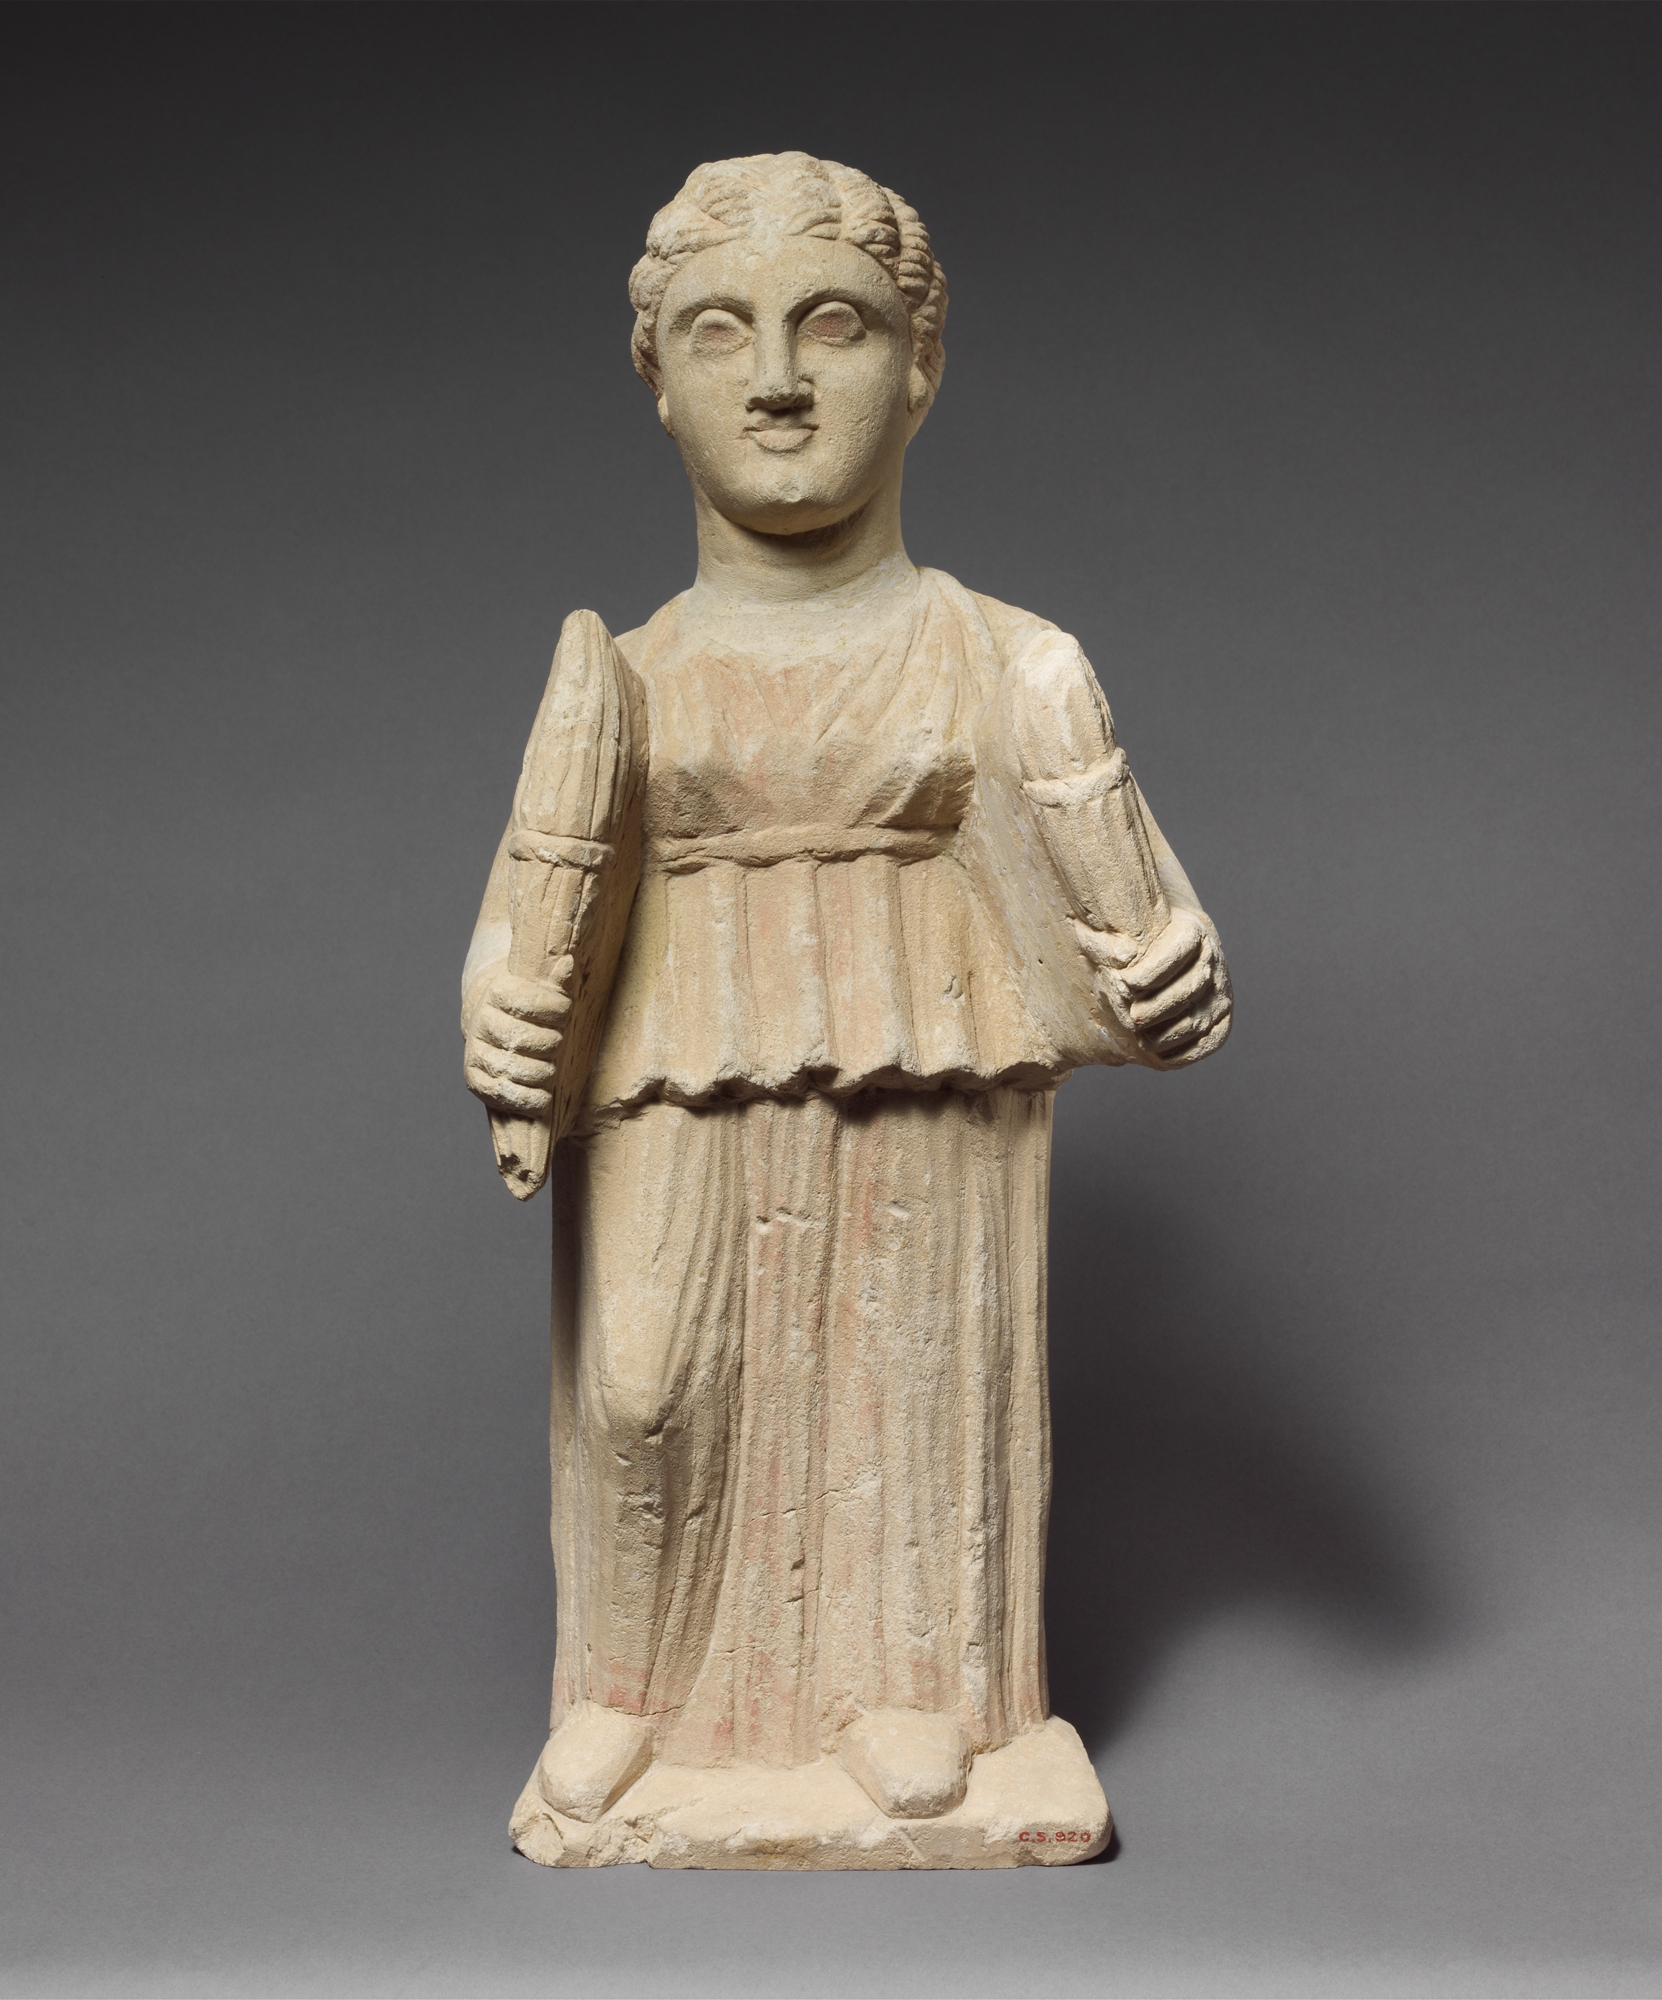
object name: statue of artemis hekate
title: Limestone statuette of Artemis (?) holding two torches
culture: cypriot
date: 300-1 BCE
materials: limestone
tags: artemis